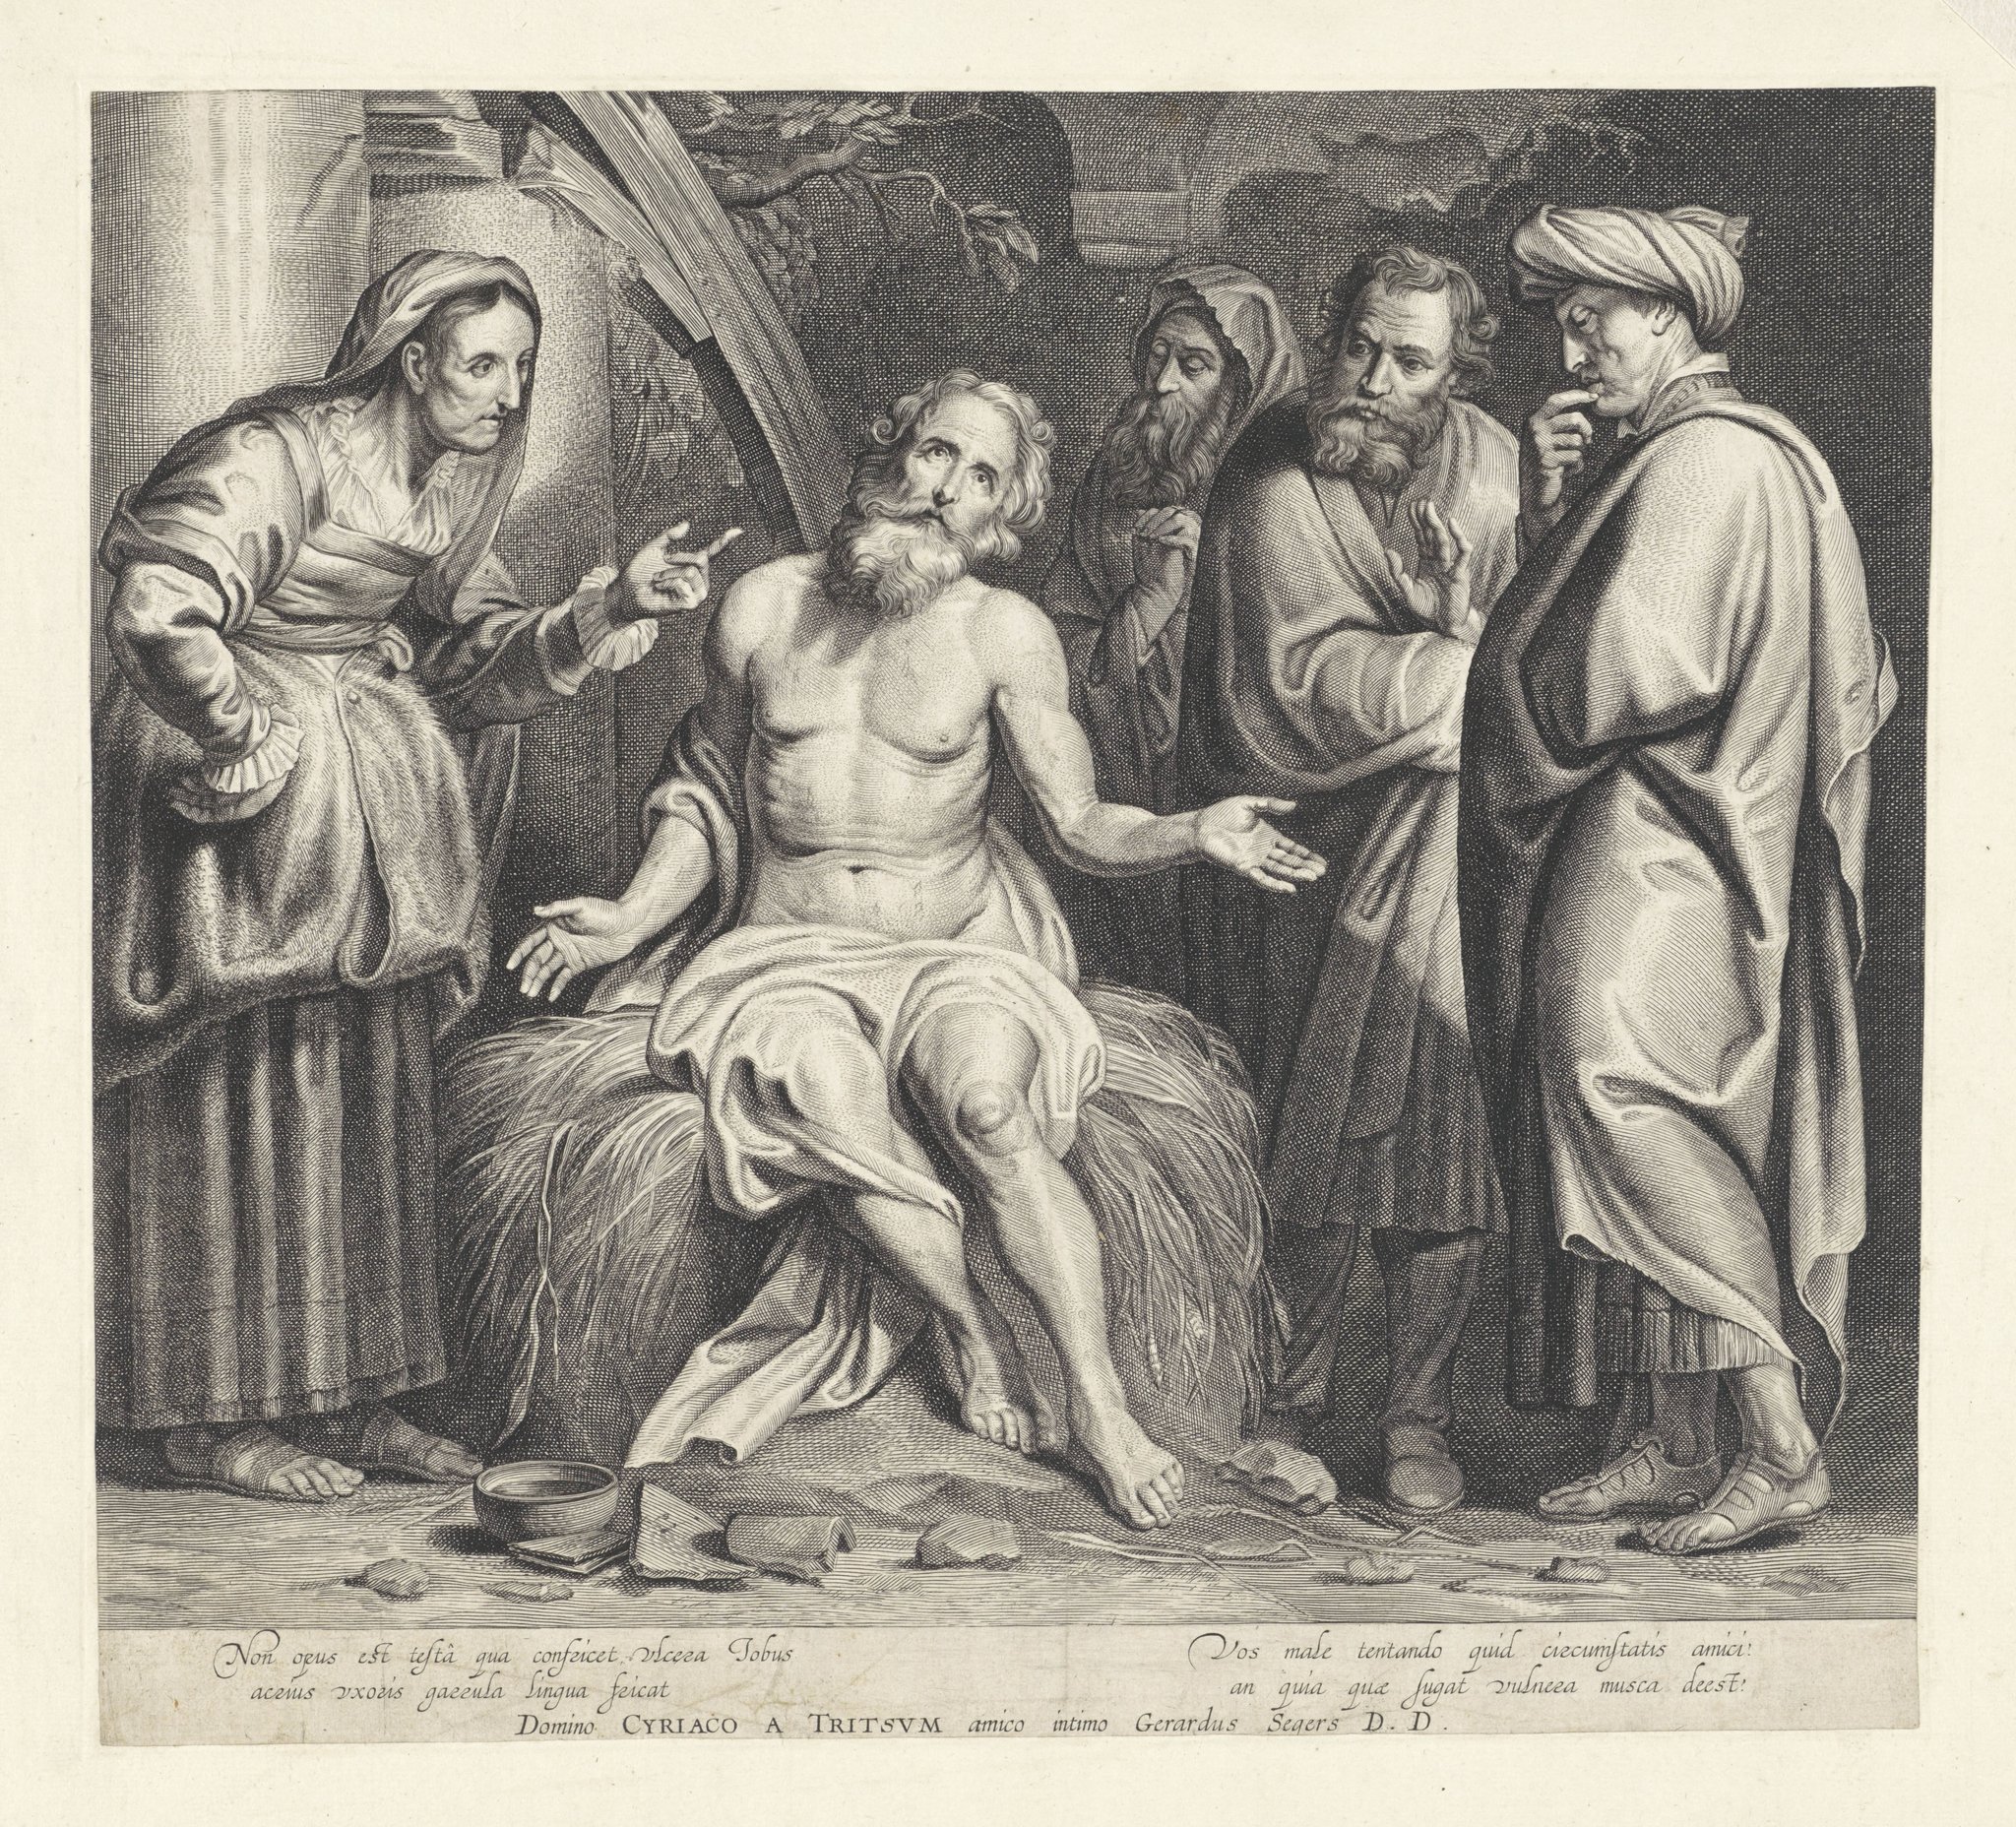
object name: print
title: Job op de mesthoop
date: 1603-1701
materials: paper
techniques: engraving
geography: antwerp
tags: job on the dunghill visited by his friends (and wife)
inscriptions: collector's mark: Lugt 240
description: Job zit op de mesthoop om aan te tonen dat hij ook in tijden van rampspoed aan zijn geloof vasthield. Zijn vrouw maakt een vermanend gebaar. Rechts staan drie vrienden. Onder in de marge een vierregelige, Latijnse tekst over de voorstelling en een éénregelige opdracht in het Latijn.